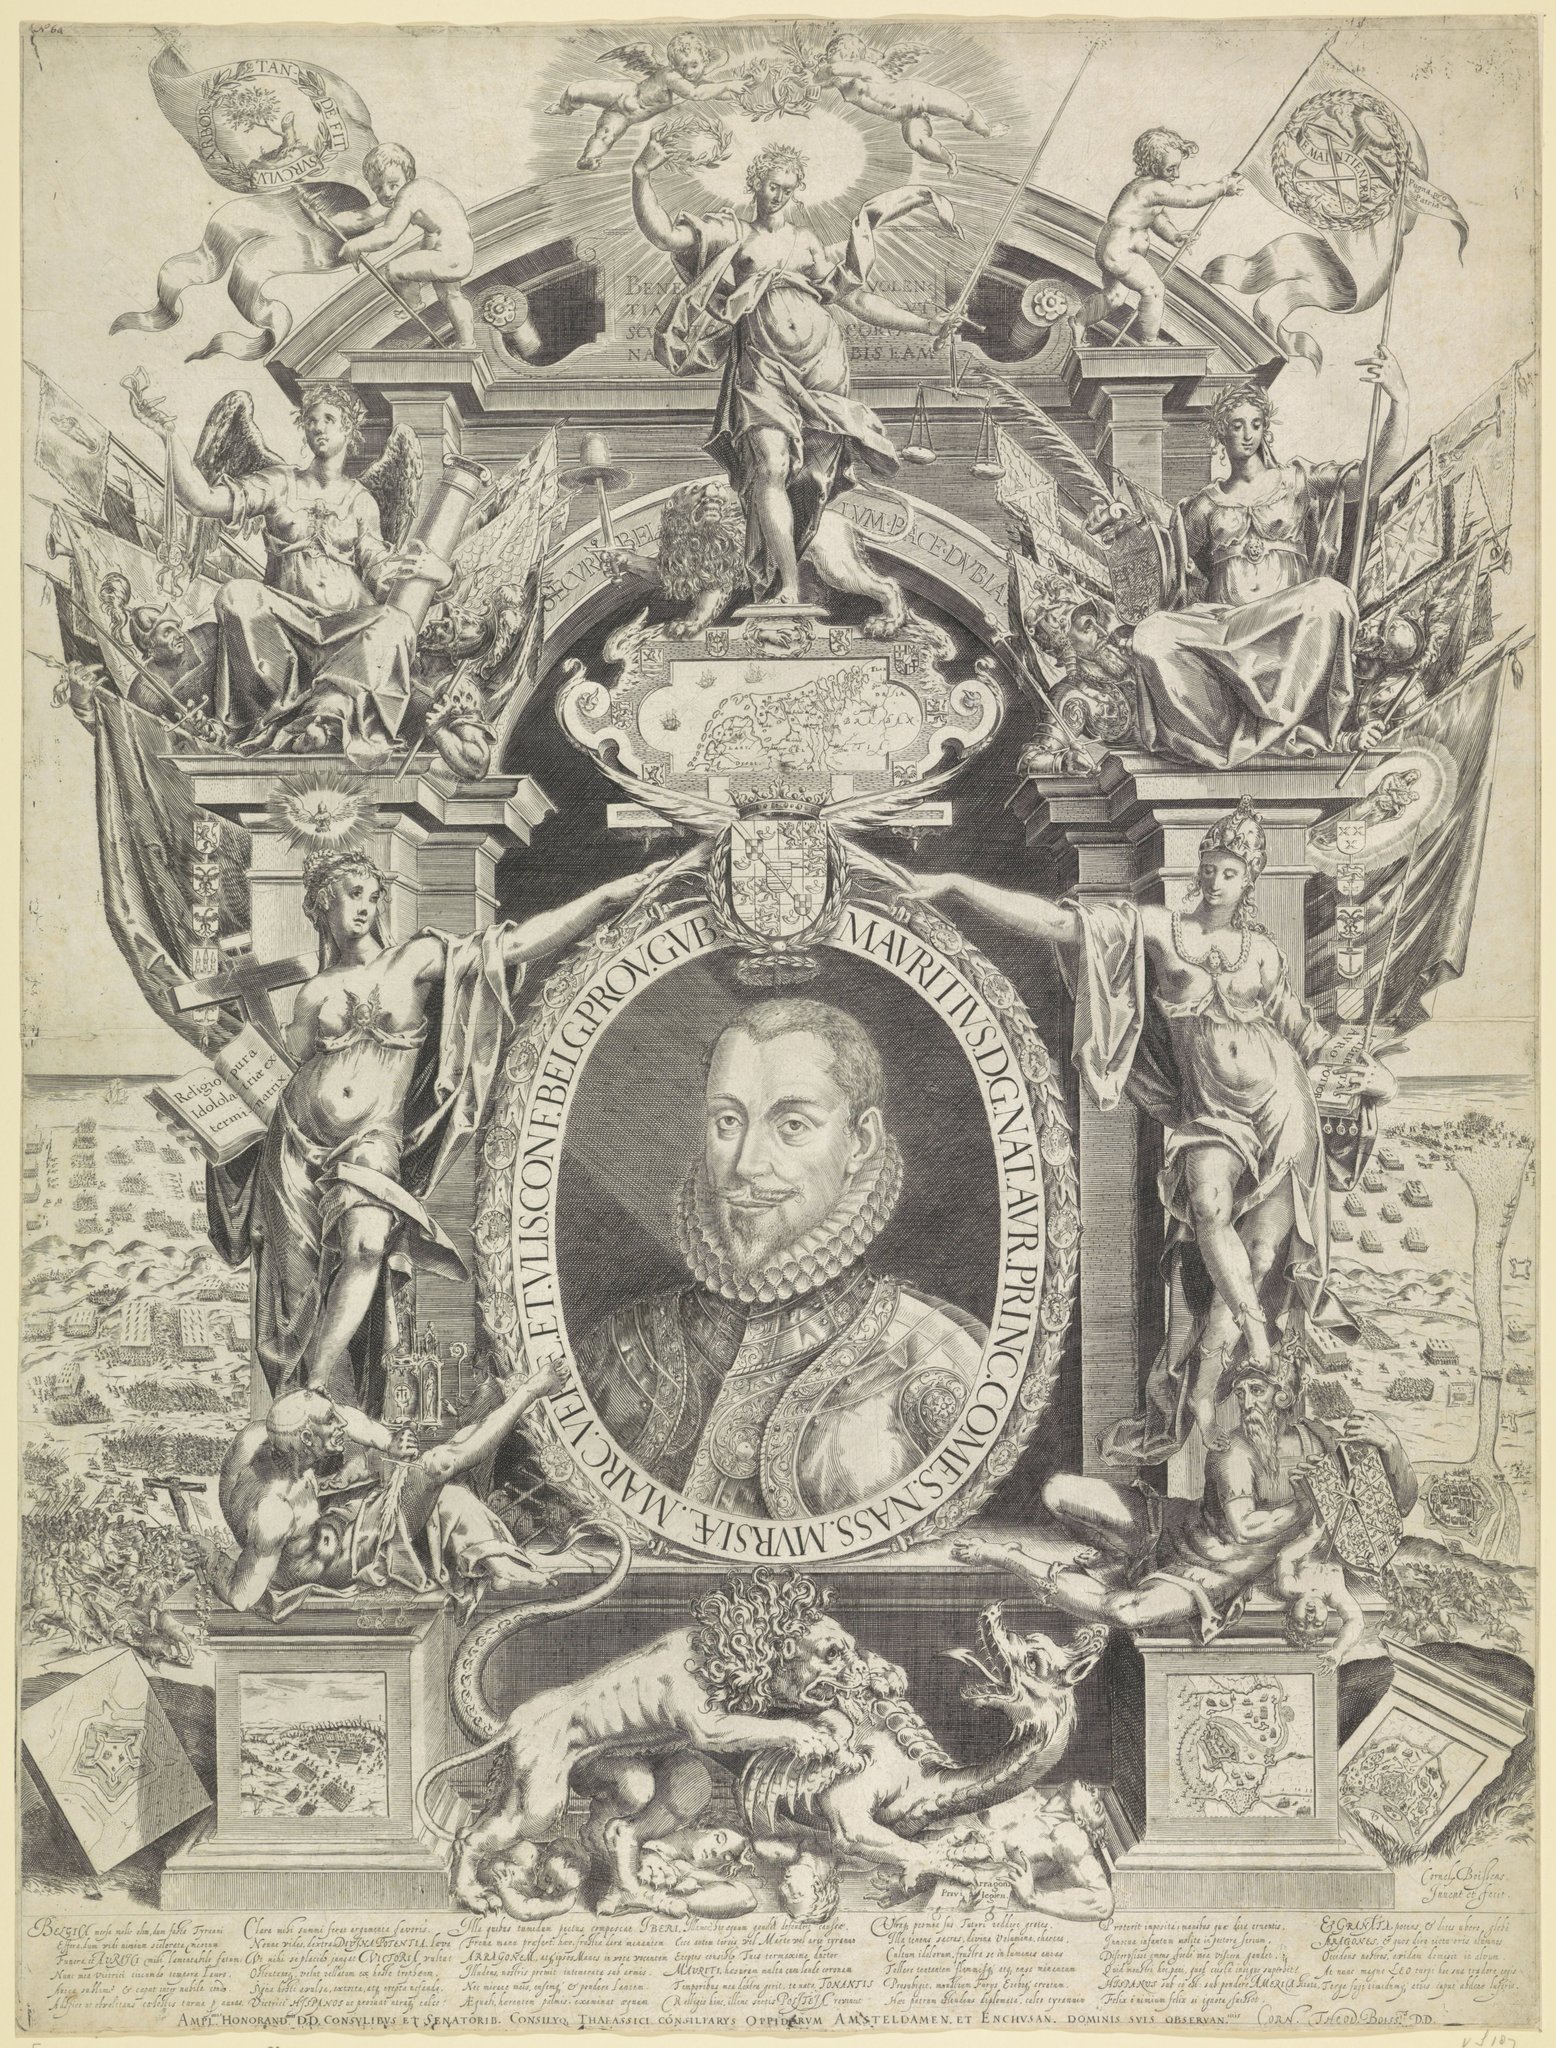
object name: print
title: Portret van Maurits, prins van Oranje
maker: cornelis dircksz. boissens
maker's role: draughtsman, print maker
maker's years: 1567-1635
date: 1593-1634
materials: paper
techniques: engraving, etching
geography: northern netherlands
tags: the hague, maurice (prince of orange)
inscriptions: collector's mark: Lugt 963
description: Portret van Maurits in een allegorische omlijsting. Aan weerszijden van het portret Ware Religie die triomfeert over de Katholieke Kerk en Vrijheid die Tirannie of Geweld vertrapt. Boven andere zegevierende allegorische figuren. Op de achtergrond en in de omlijsting zijn voorstellingen van veldslagen, kaartjes en plattegronden verwerkt. Onder het portret een Latijns onderschrift van zeven verzen.